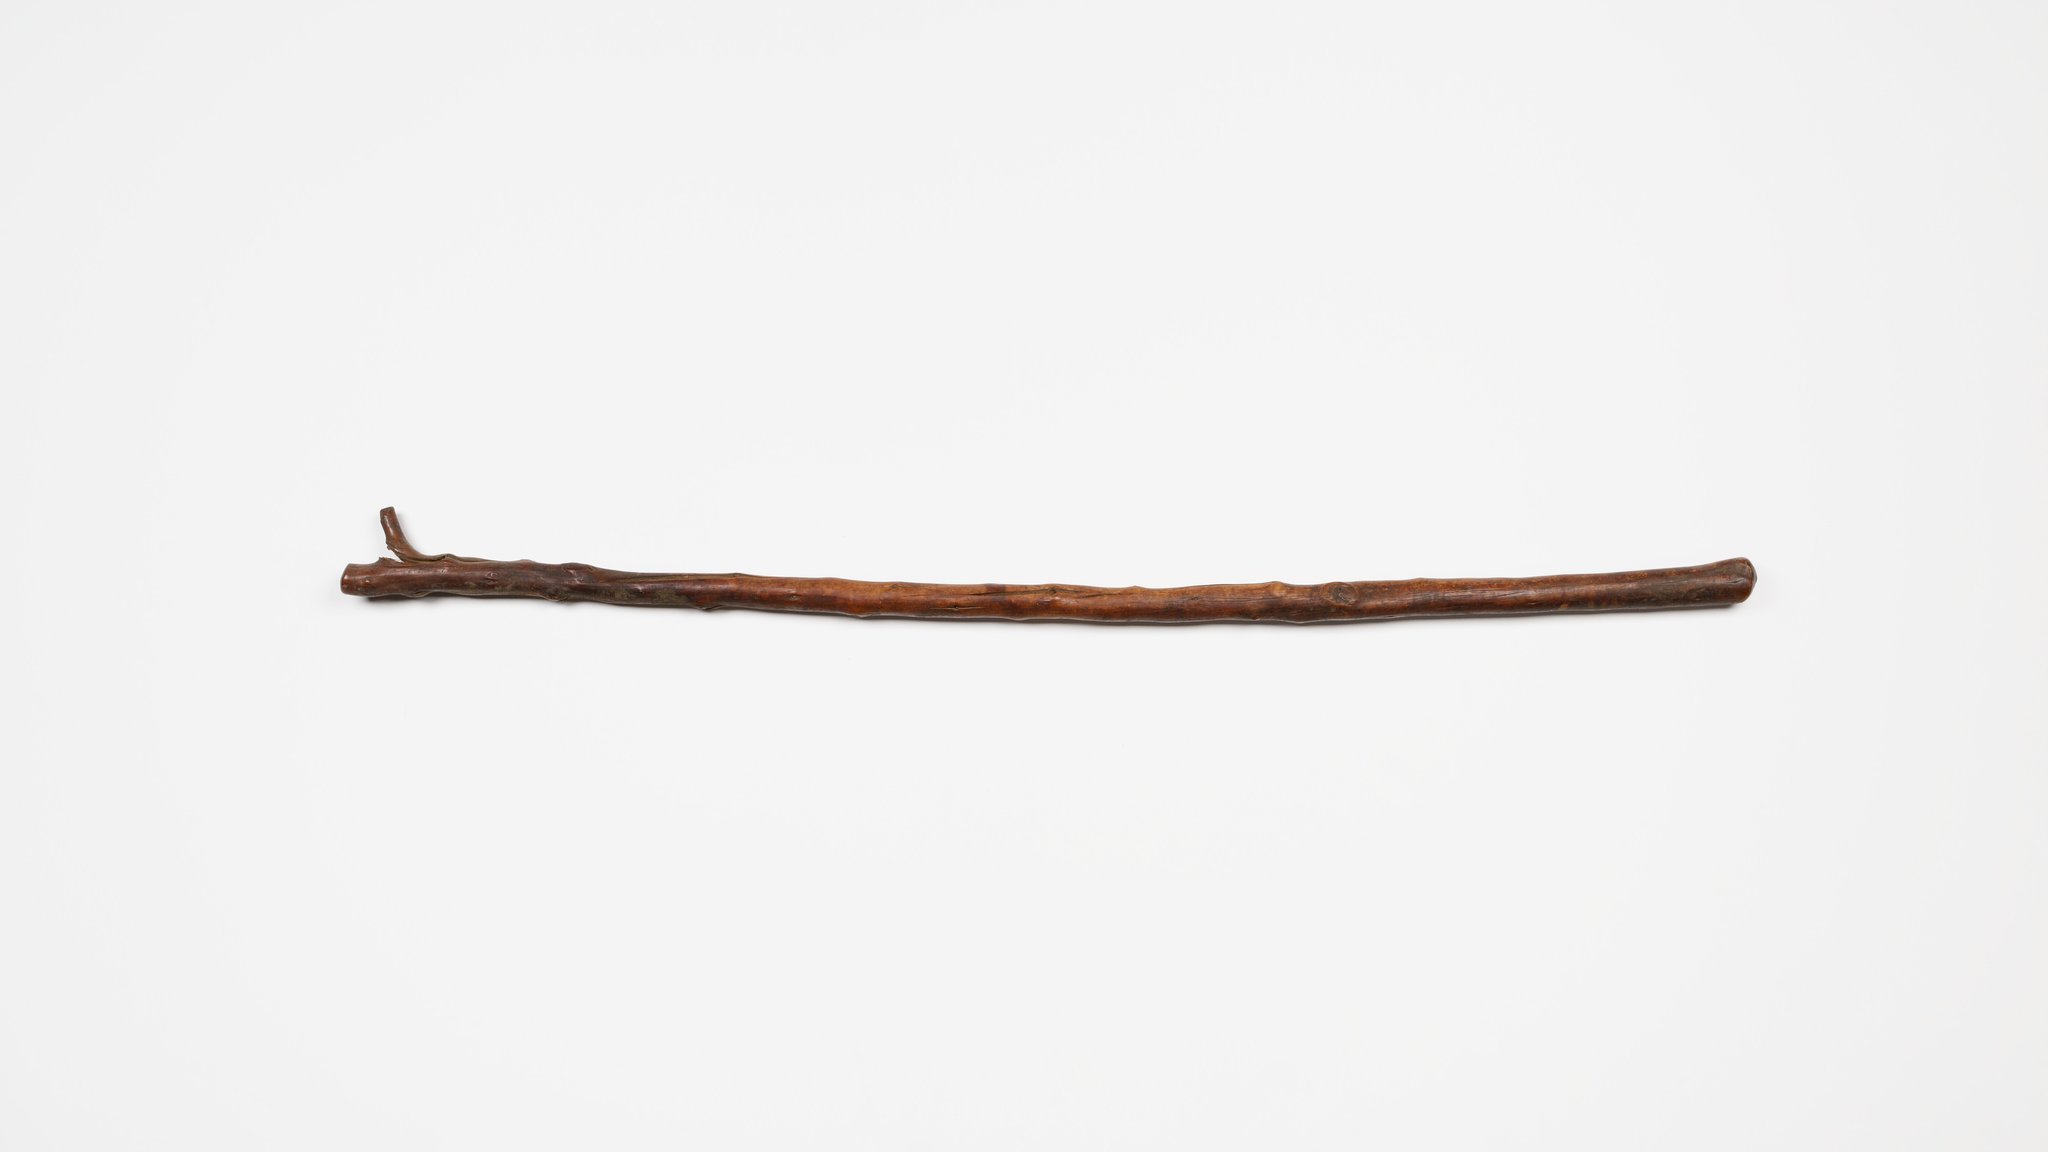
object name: staff, lady djabwet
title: Staff of Lady Djabwet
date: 2124-1504 BCE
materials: wood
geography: egypt